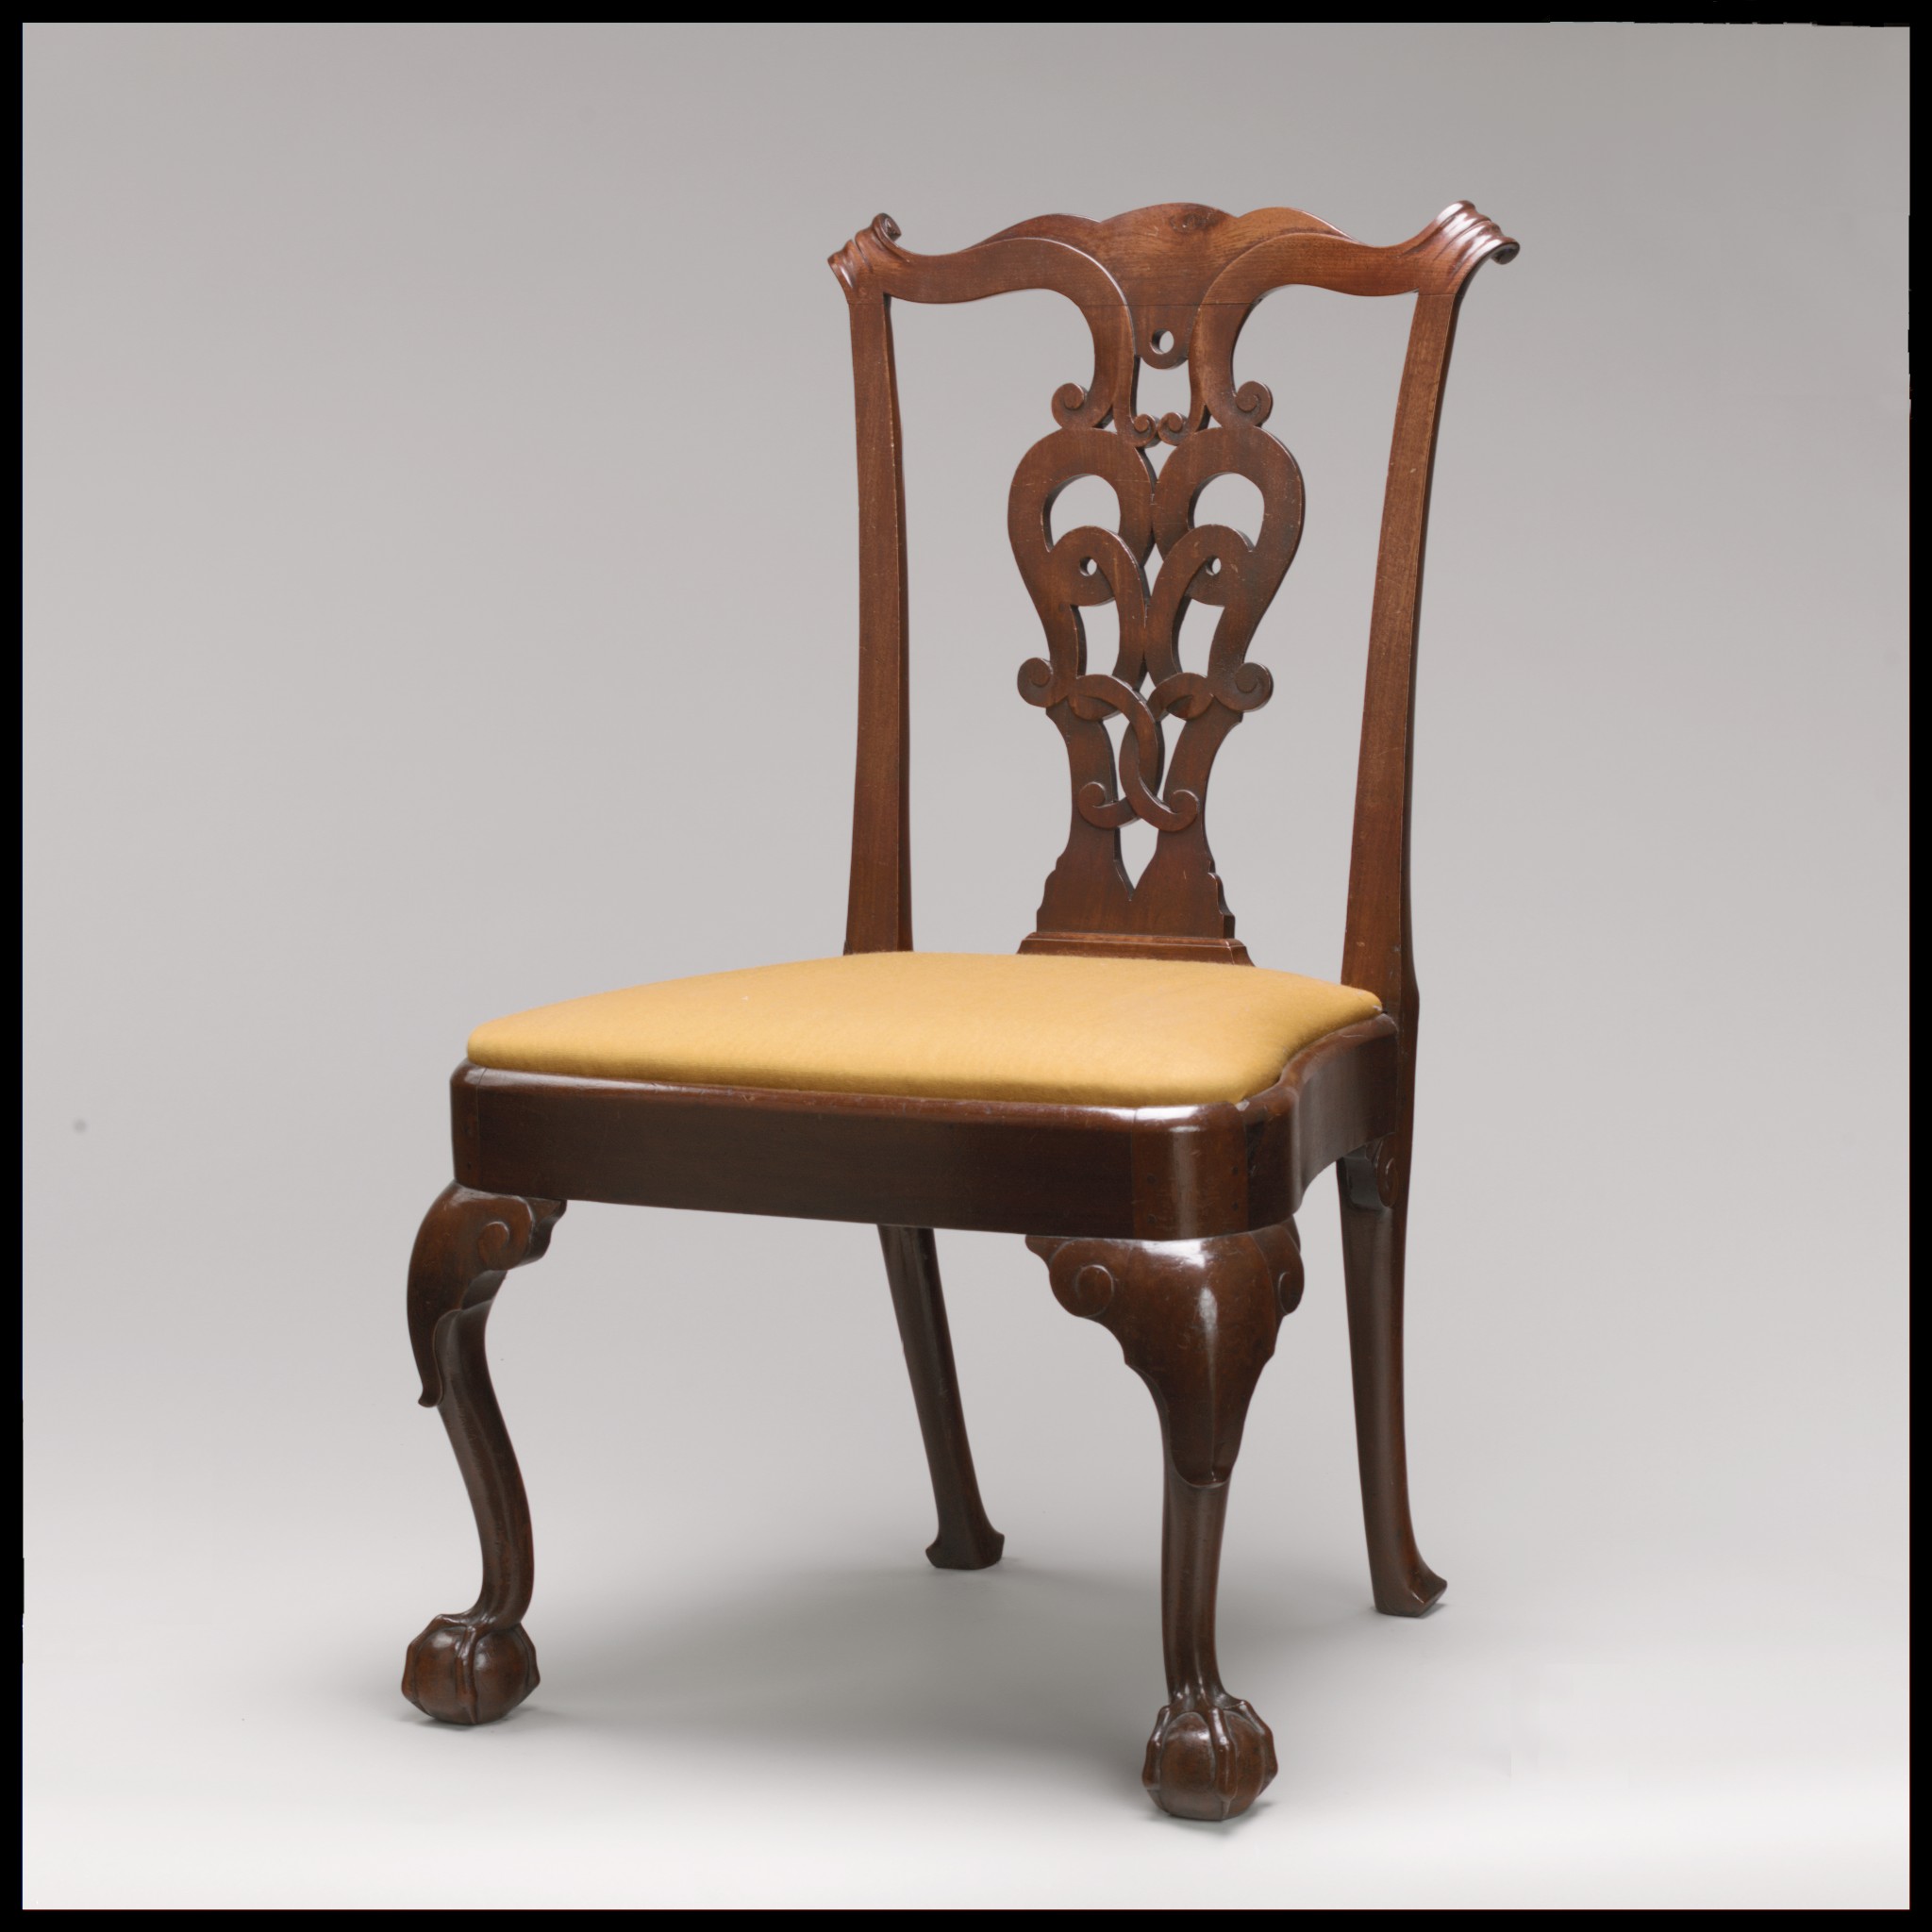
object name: side chair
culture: american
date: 1760-1790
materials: wood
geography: united states